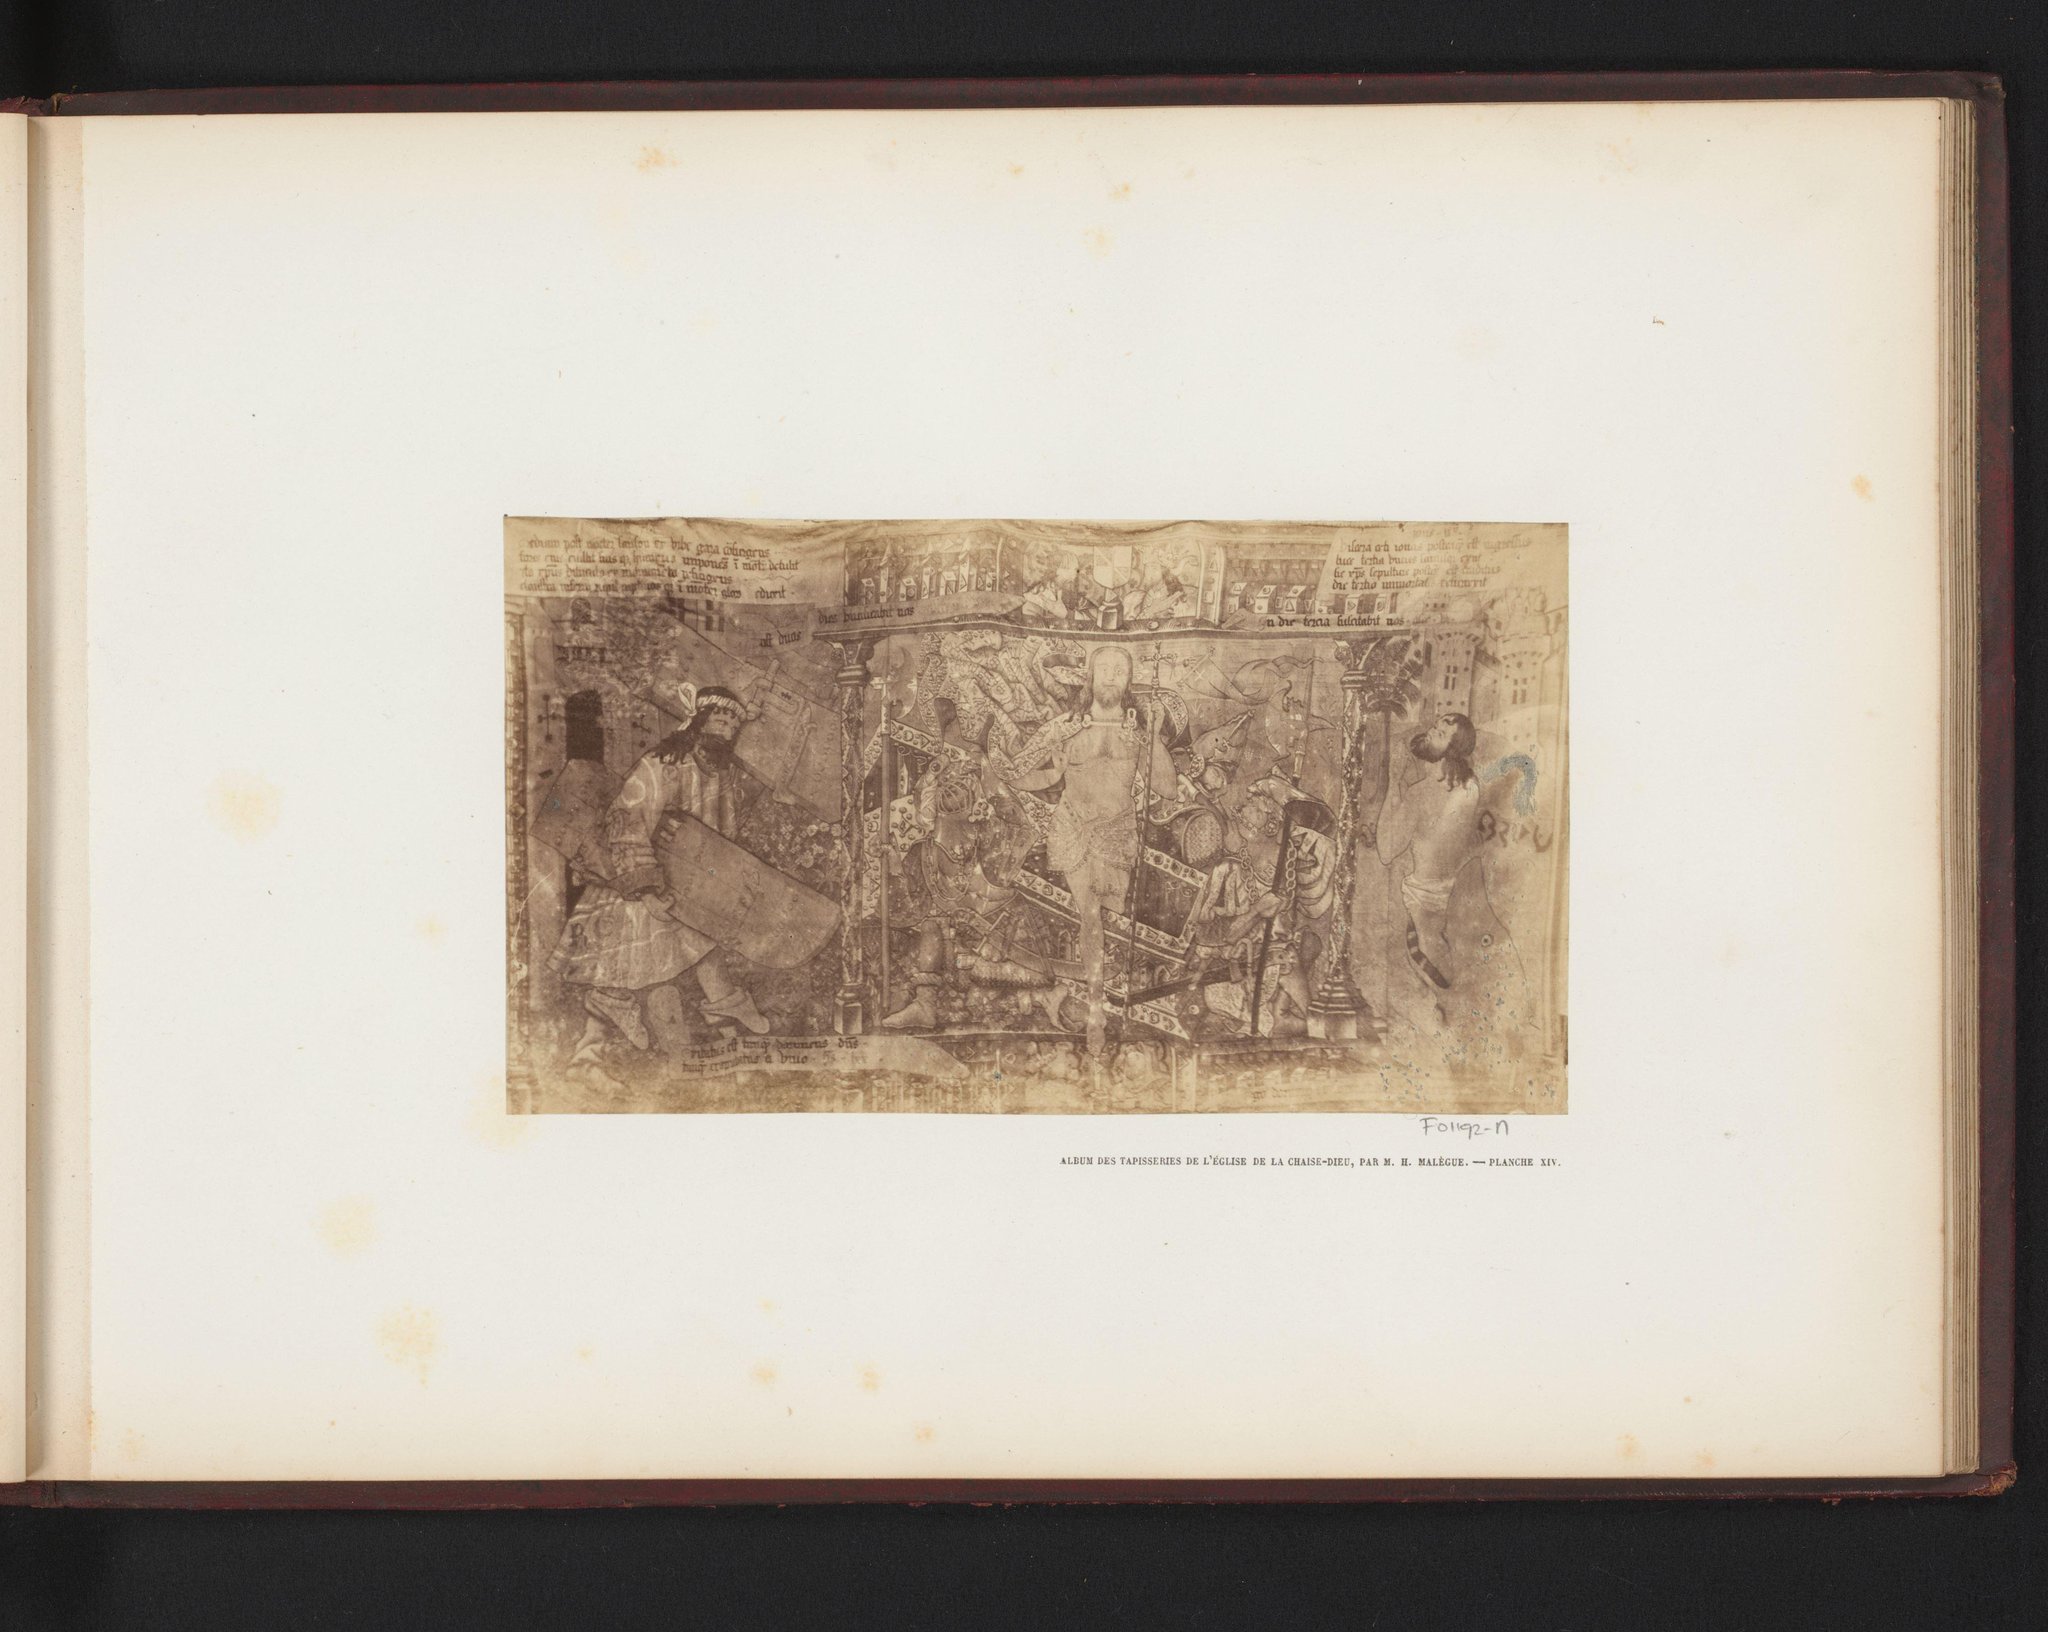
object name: photograph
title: Tapijt met de opstanding van Christus en prefiguraties in een kerk te La Chaise-Dieu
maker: hippolyte malègue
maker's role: archeoloog, fotograaf, schrijver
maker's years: 1825-1901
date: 1868-1873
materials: photographic support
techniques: albumen print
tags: tapestry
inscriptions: inscription: ‘album des tapisseries de l'église de la Chaise-Dieu, par M. H. Malegue - Planche XIV’